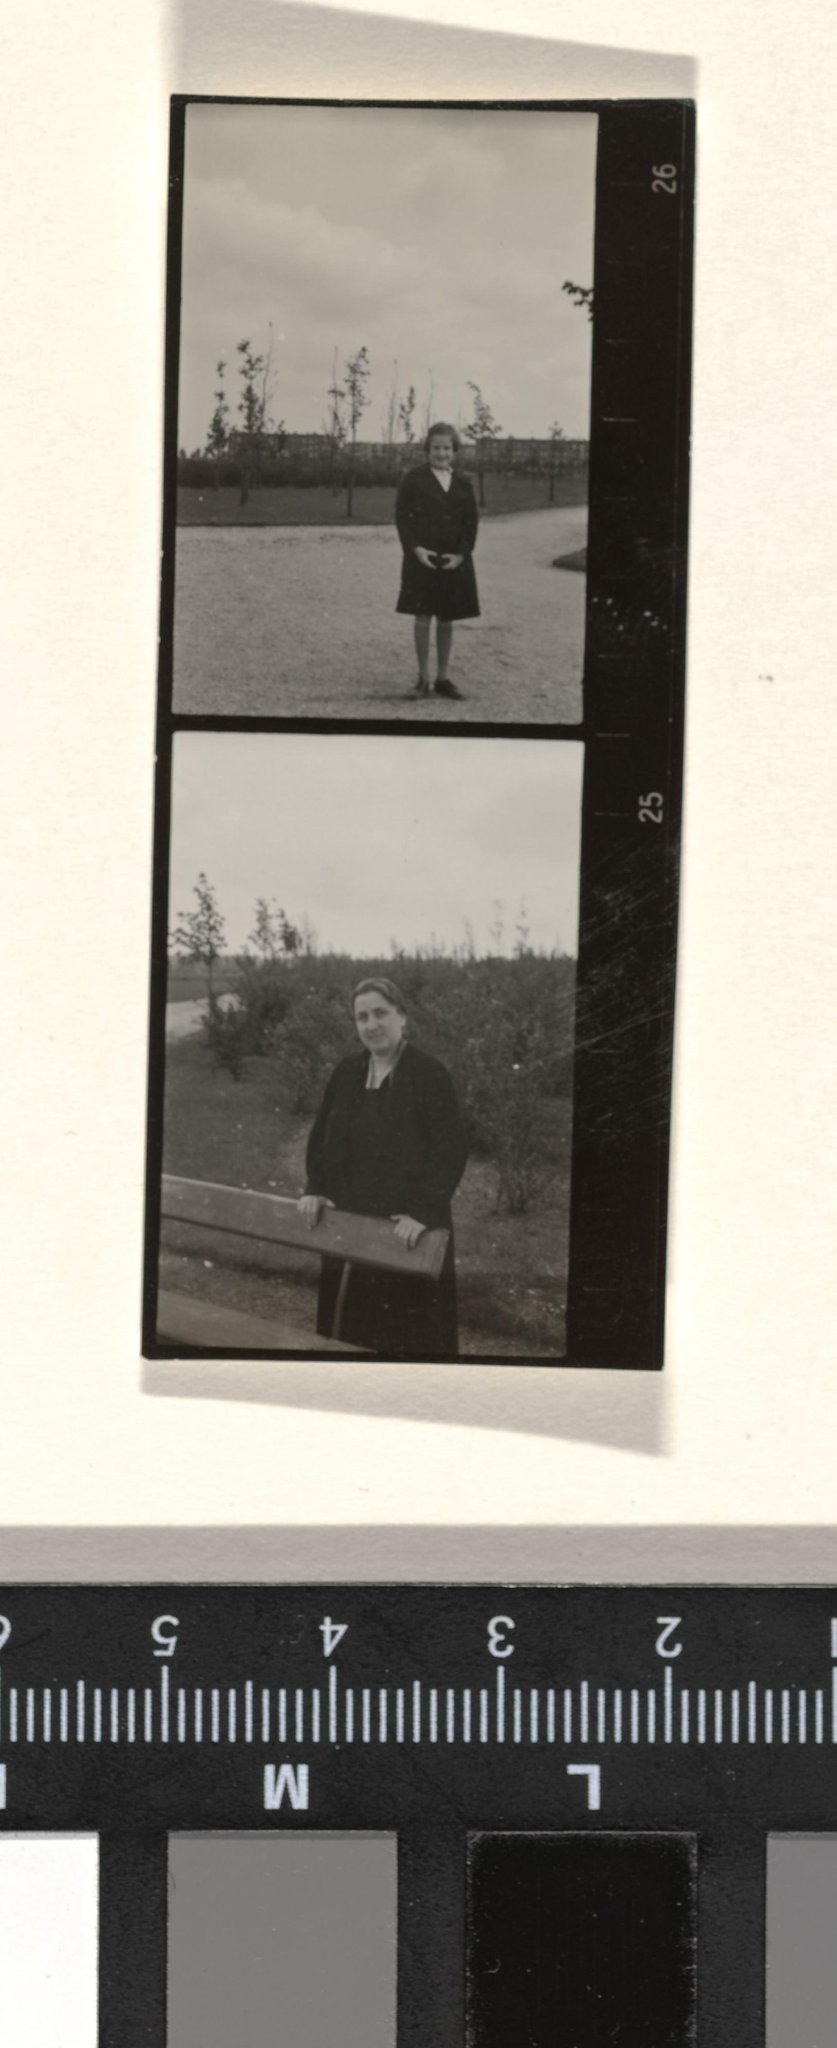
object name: photograph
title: Dubbele foto van Isabel Wachenheimer en haar moeder Else Wachenheimer-Moos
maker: Anonymous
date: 1934-1943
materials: photographic support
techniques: gelatin silver print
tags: else wachenheimer-moos, leiden, isabel wachenheimer-elon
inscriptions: number: ‘3x 6x’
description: Isabel Wachenheimer en Else Wachenheimer-Moos in de openlucht.